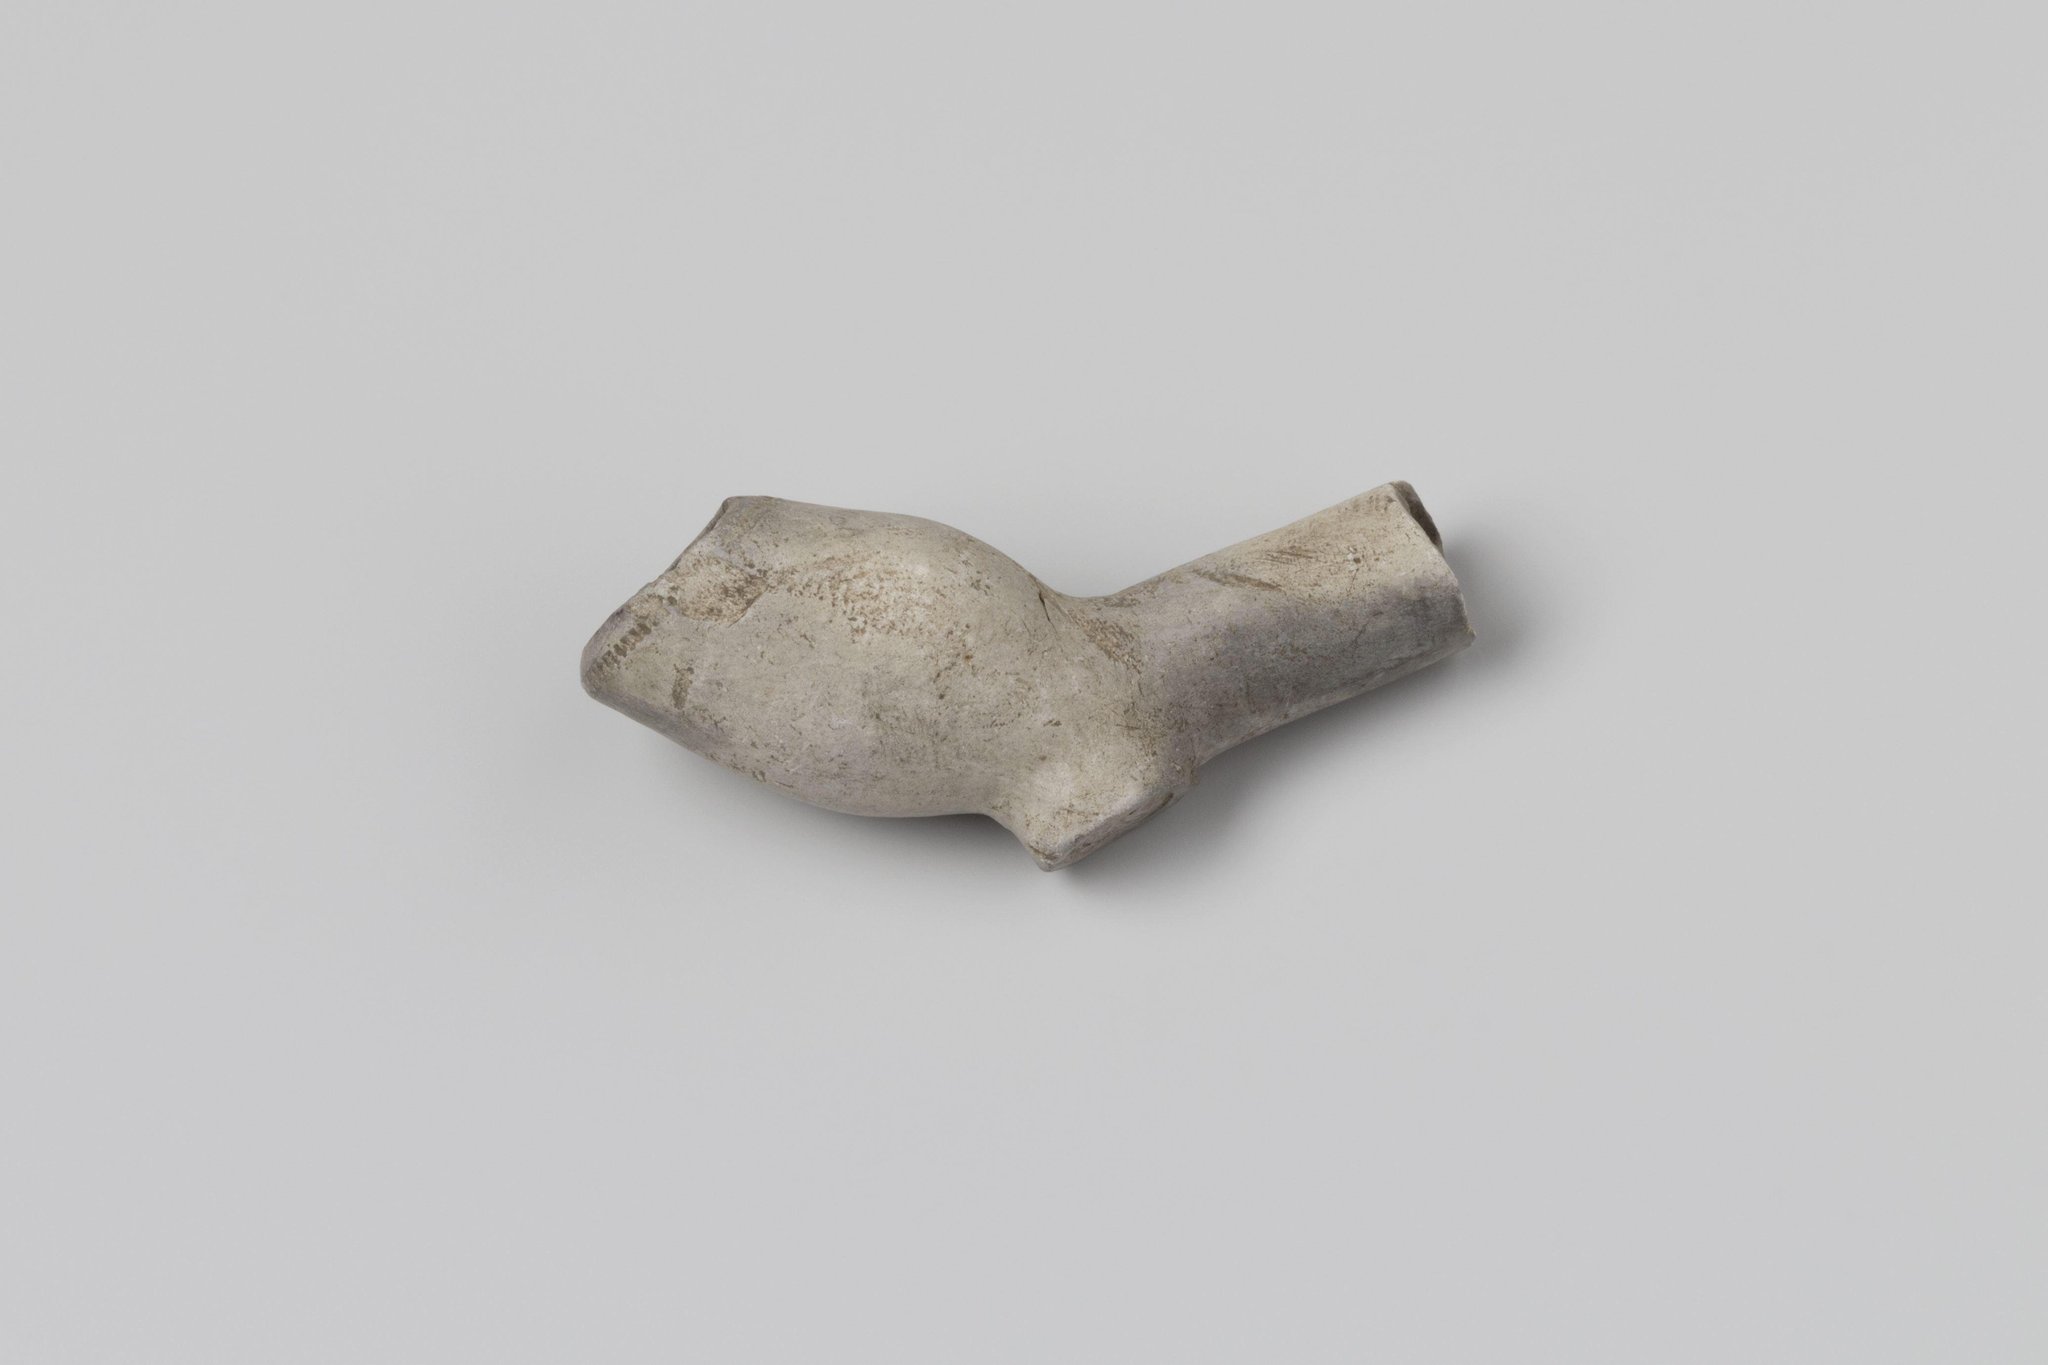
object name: pipe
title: Fragment tabakspijp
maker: willem pouwel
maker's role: pijpenfabrikant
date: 1635-1650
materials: clay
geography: delft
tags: the hague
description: Fragment tabakspijp. Van de opgravingen op de Hofstede Arentsburg 1827-1831 onder toezicht van Professor Reuvens.